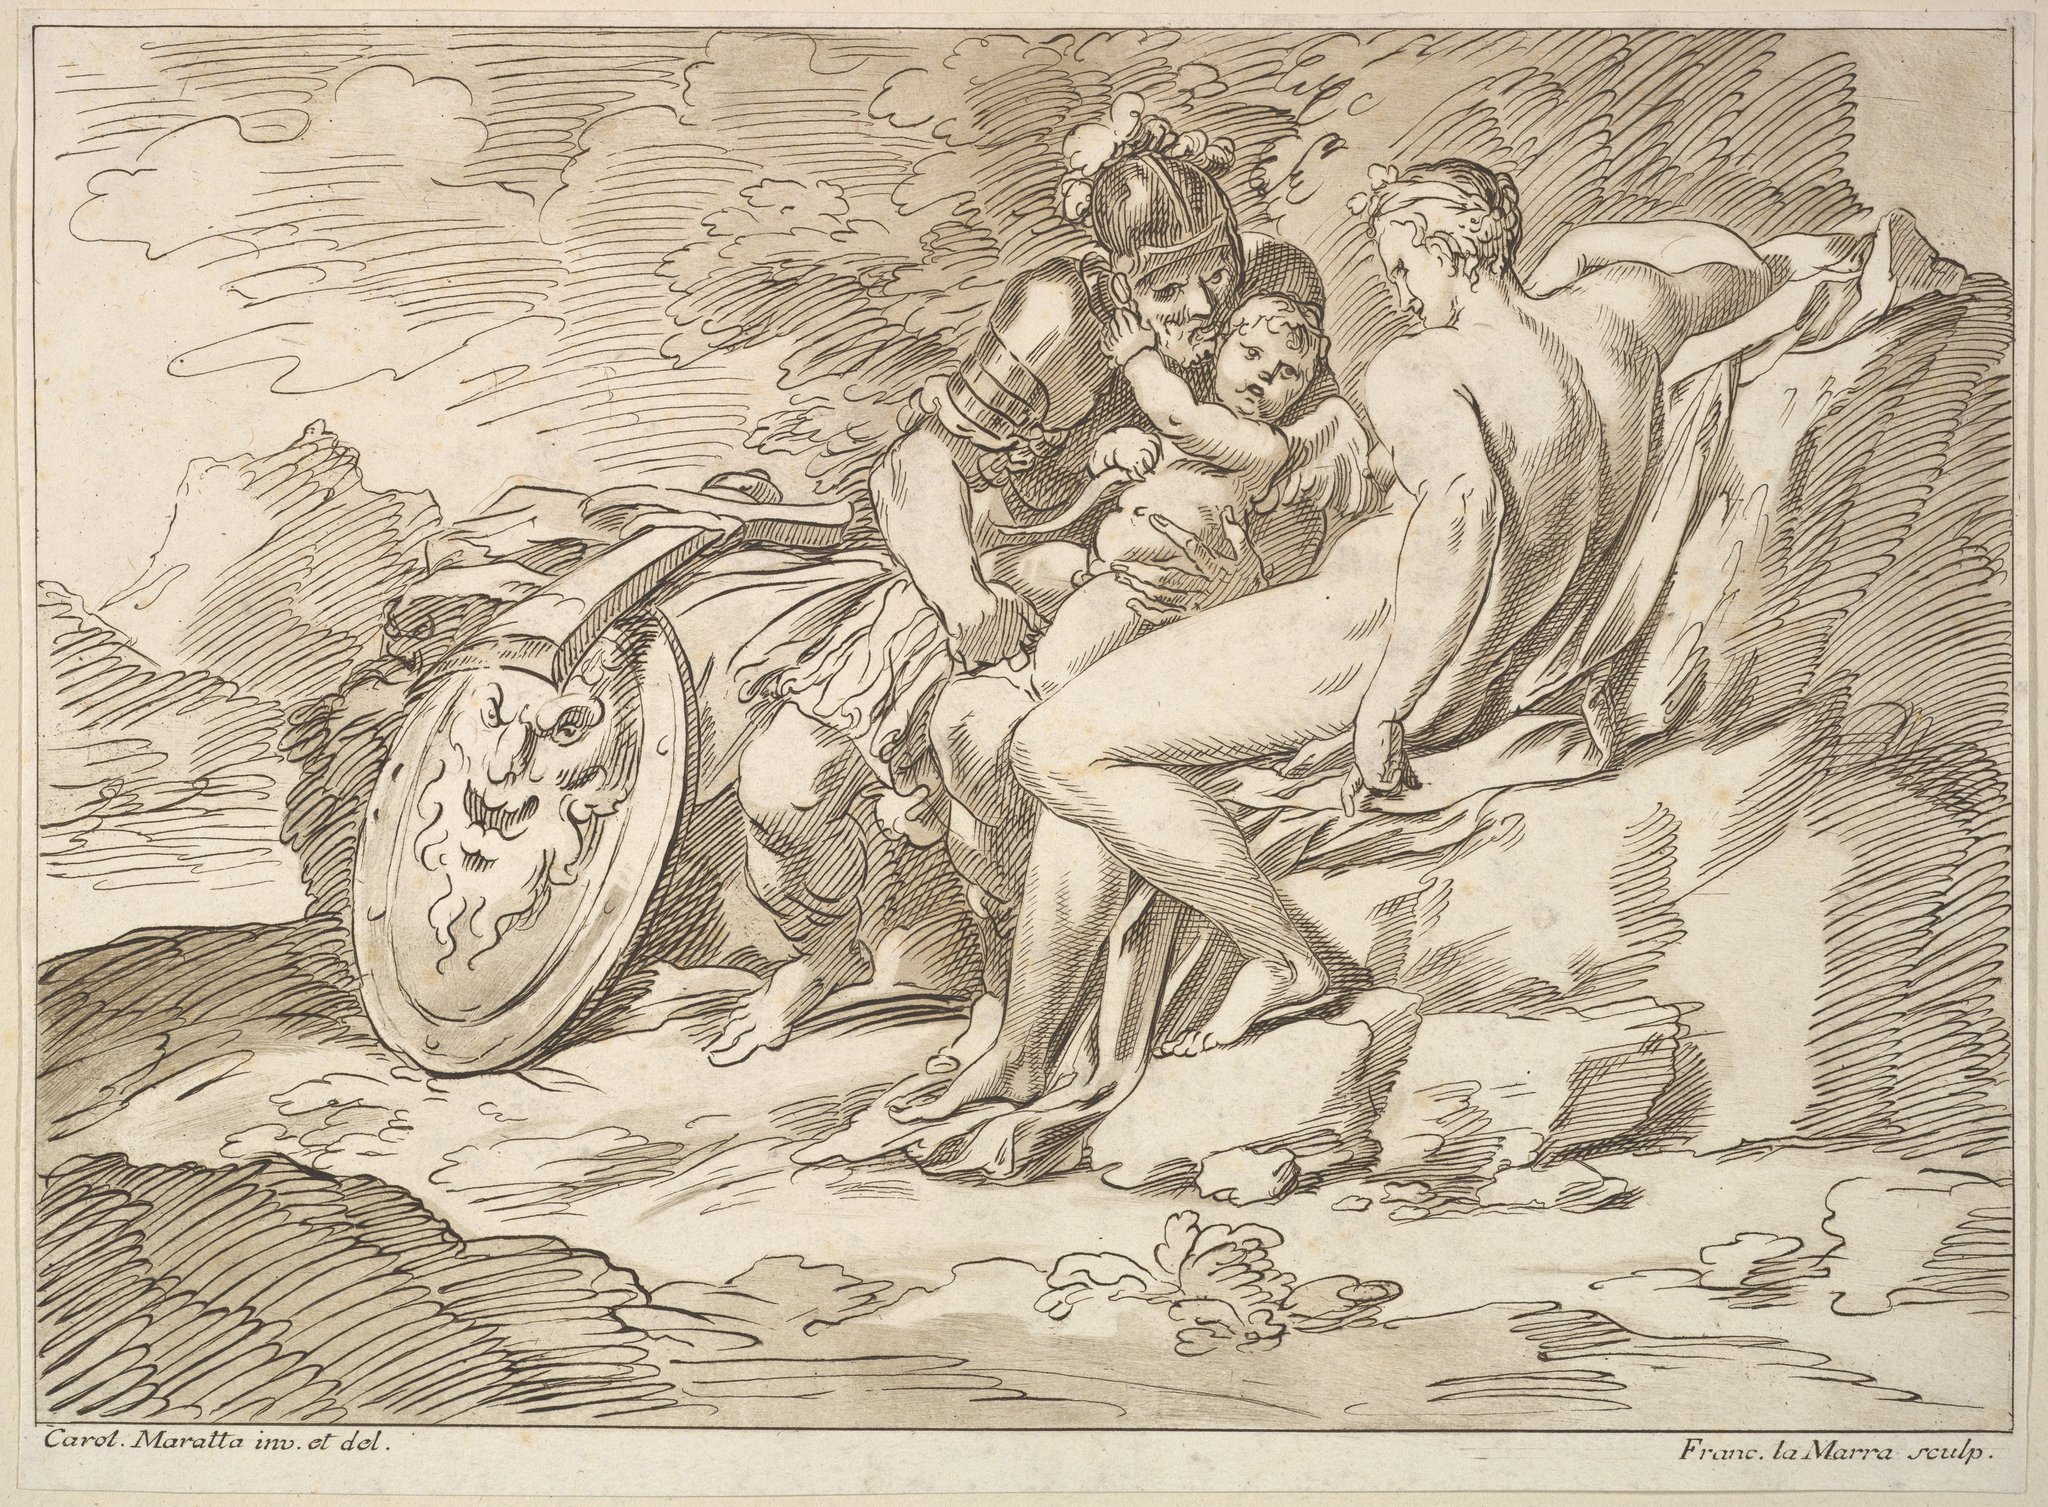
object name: print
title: Venus, Mars, and Cupid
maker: francesco lamarra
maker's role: artist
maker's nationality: italian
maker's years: 1710-1780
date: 1725-1780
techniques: etching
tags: shields,cupid,mars,venus